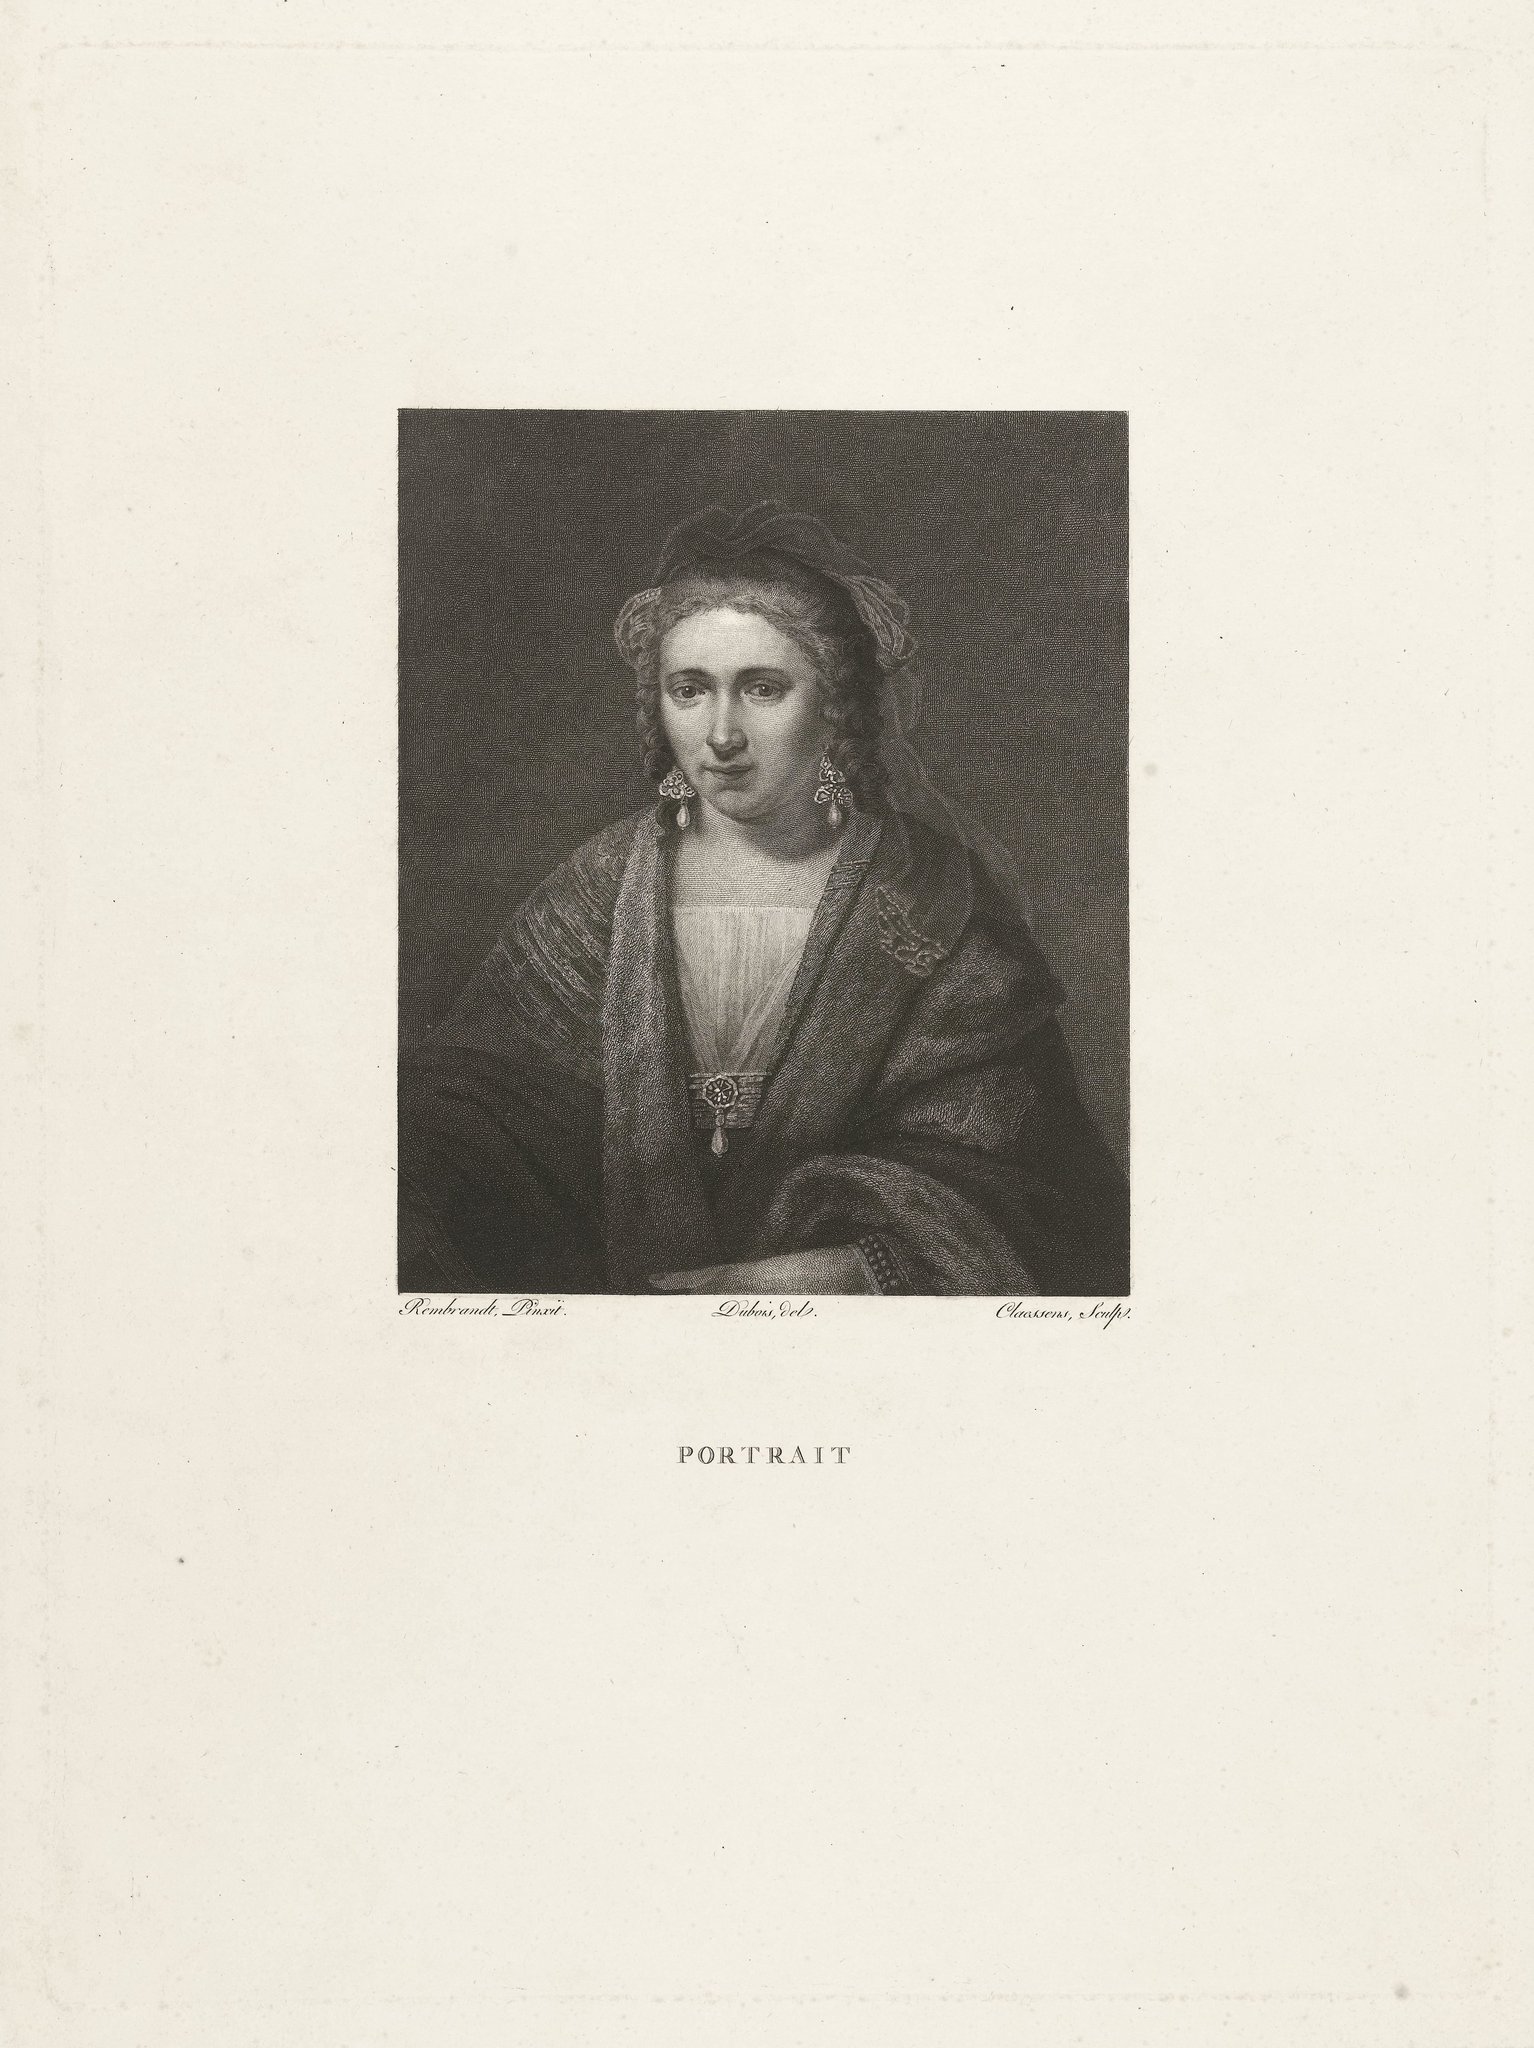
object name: print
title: Portret van een vrouw met pareloorbellen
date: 1829-1834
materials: paper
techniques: engraving, etching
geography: paris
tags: ear-rings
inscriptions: collector's mark: Lugt 2228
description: Gemaakt voor: Musée français : recueil des plus beaux tableaux, statues et bas-reliefs qui existaient au Louvre avant 1815, avec l'explication des sujets, et des discours historiques sur la peinture, la sculpture et la gravure. Paris: A. & W. Galignani & Londers, J.O. Robinson, [1829-39]